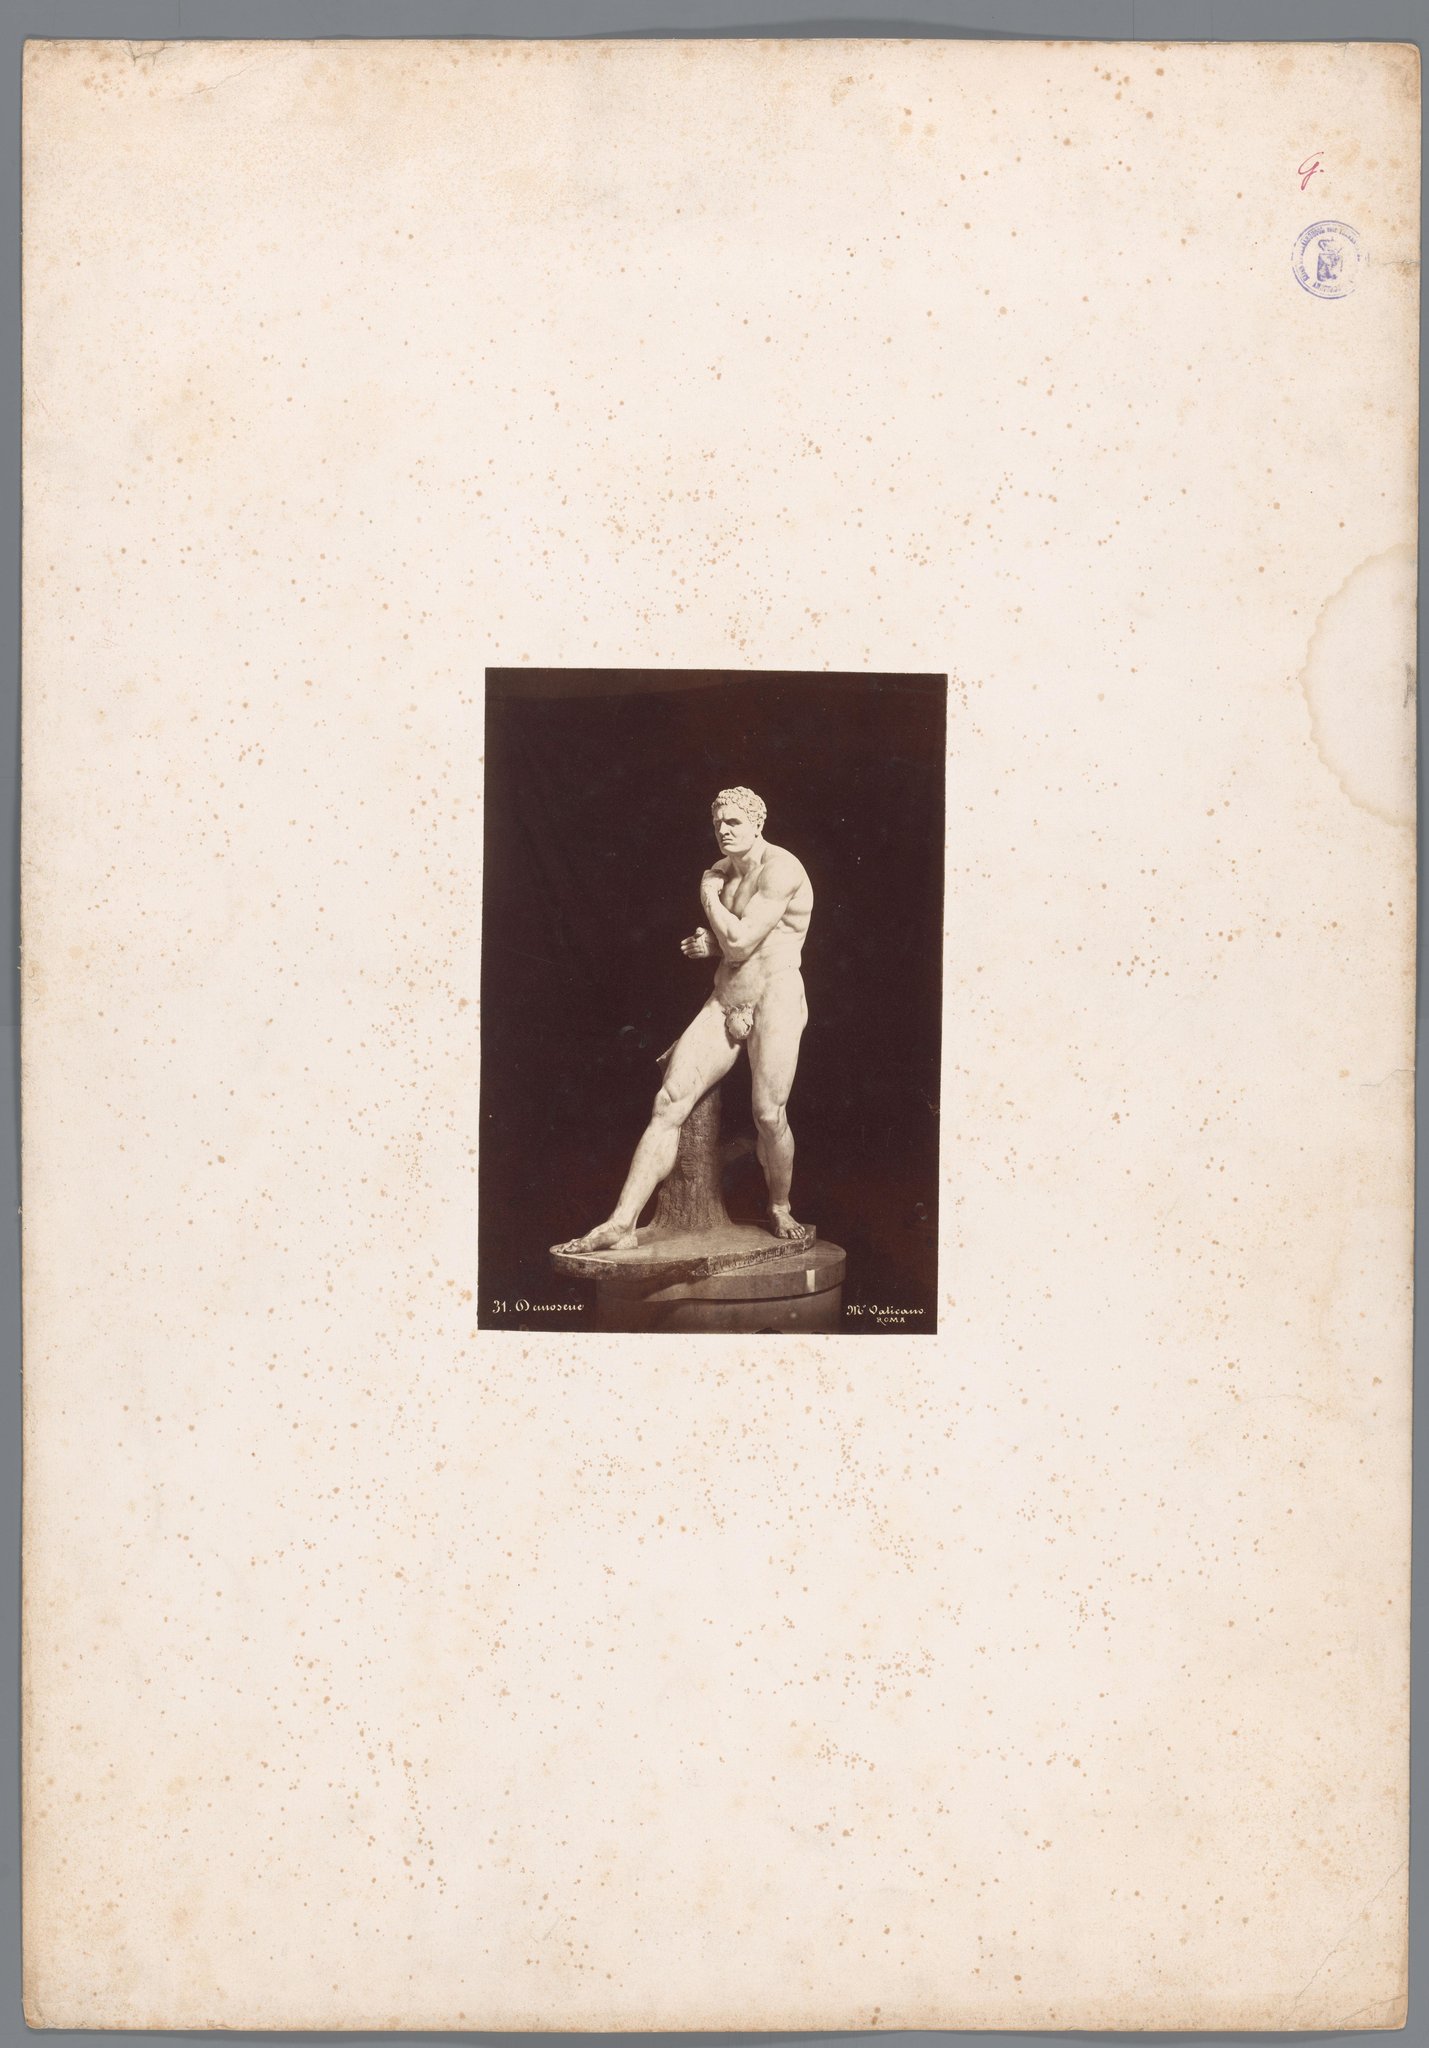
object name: photograph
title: Beeld van Demosthenes uit de Vaticaanse Musea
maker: Anonymous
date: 1880-1900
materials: cardboard, paper, photographic support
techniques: albumen print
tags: politician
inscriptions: stamp, : ‘G’, : ‘31. Demosene Mo Vaticano / ROMA’